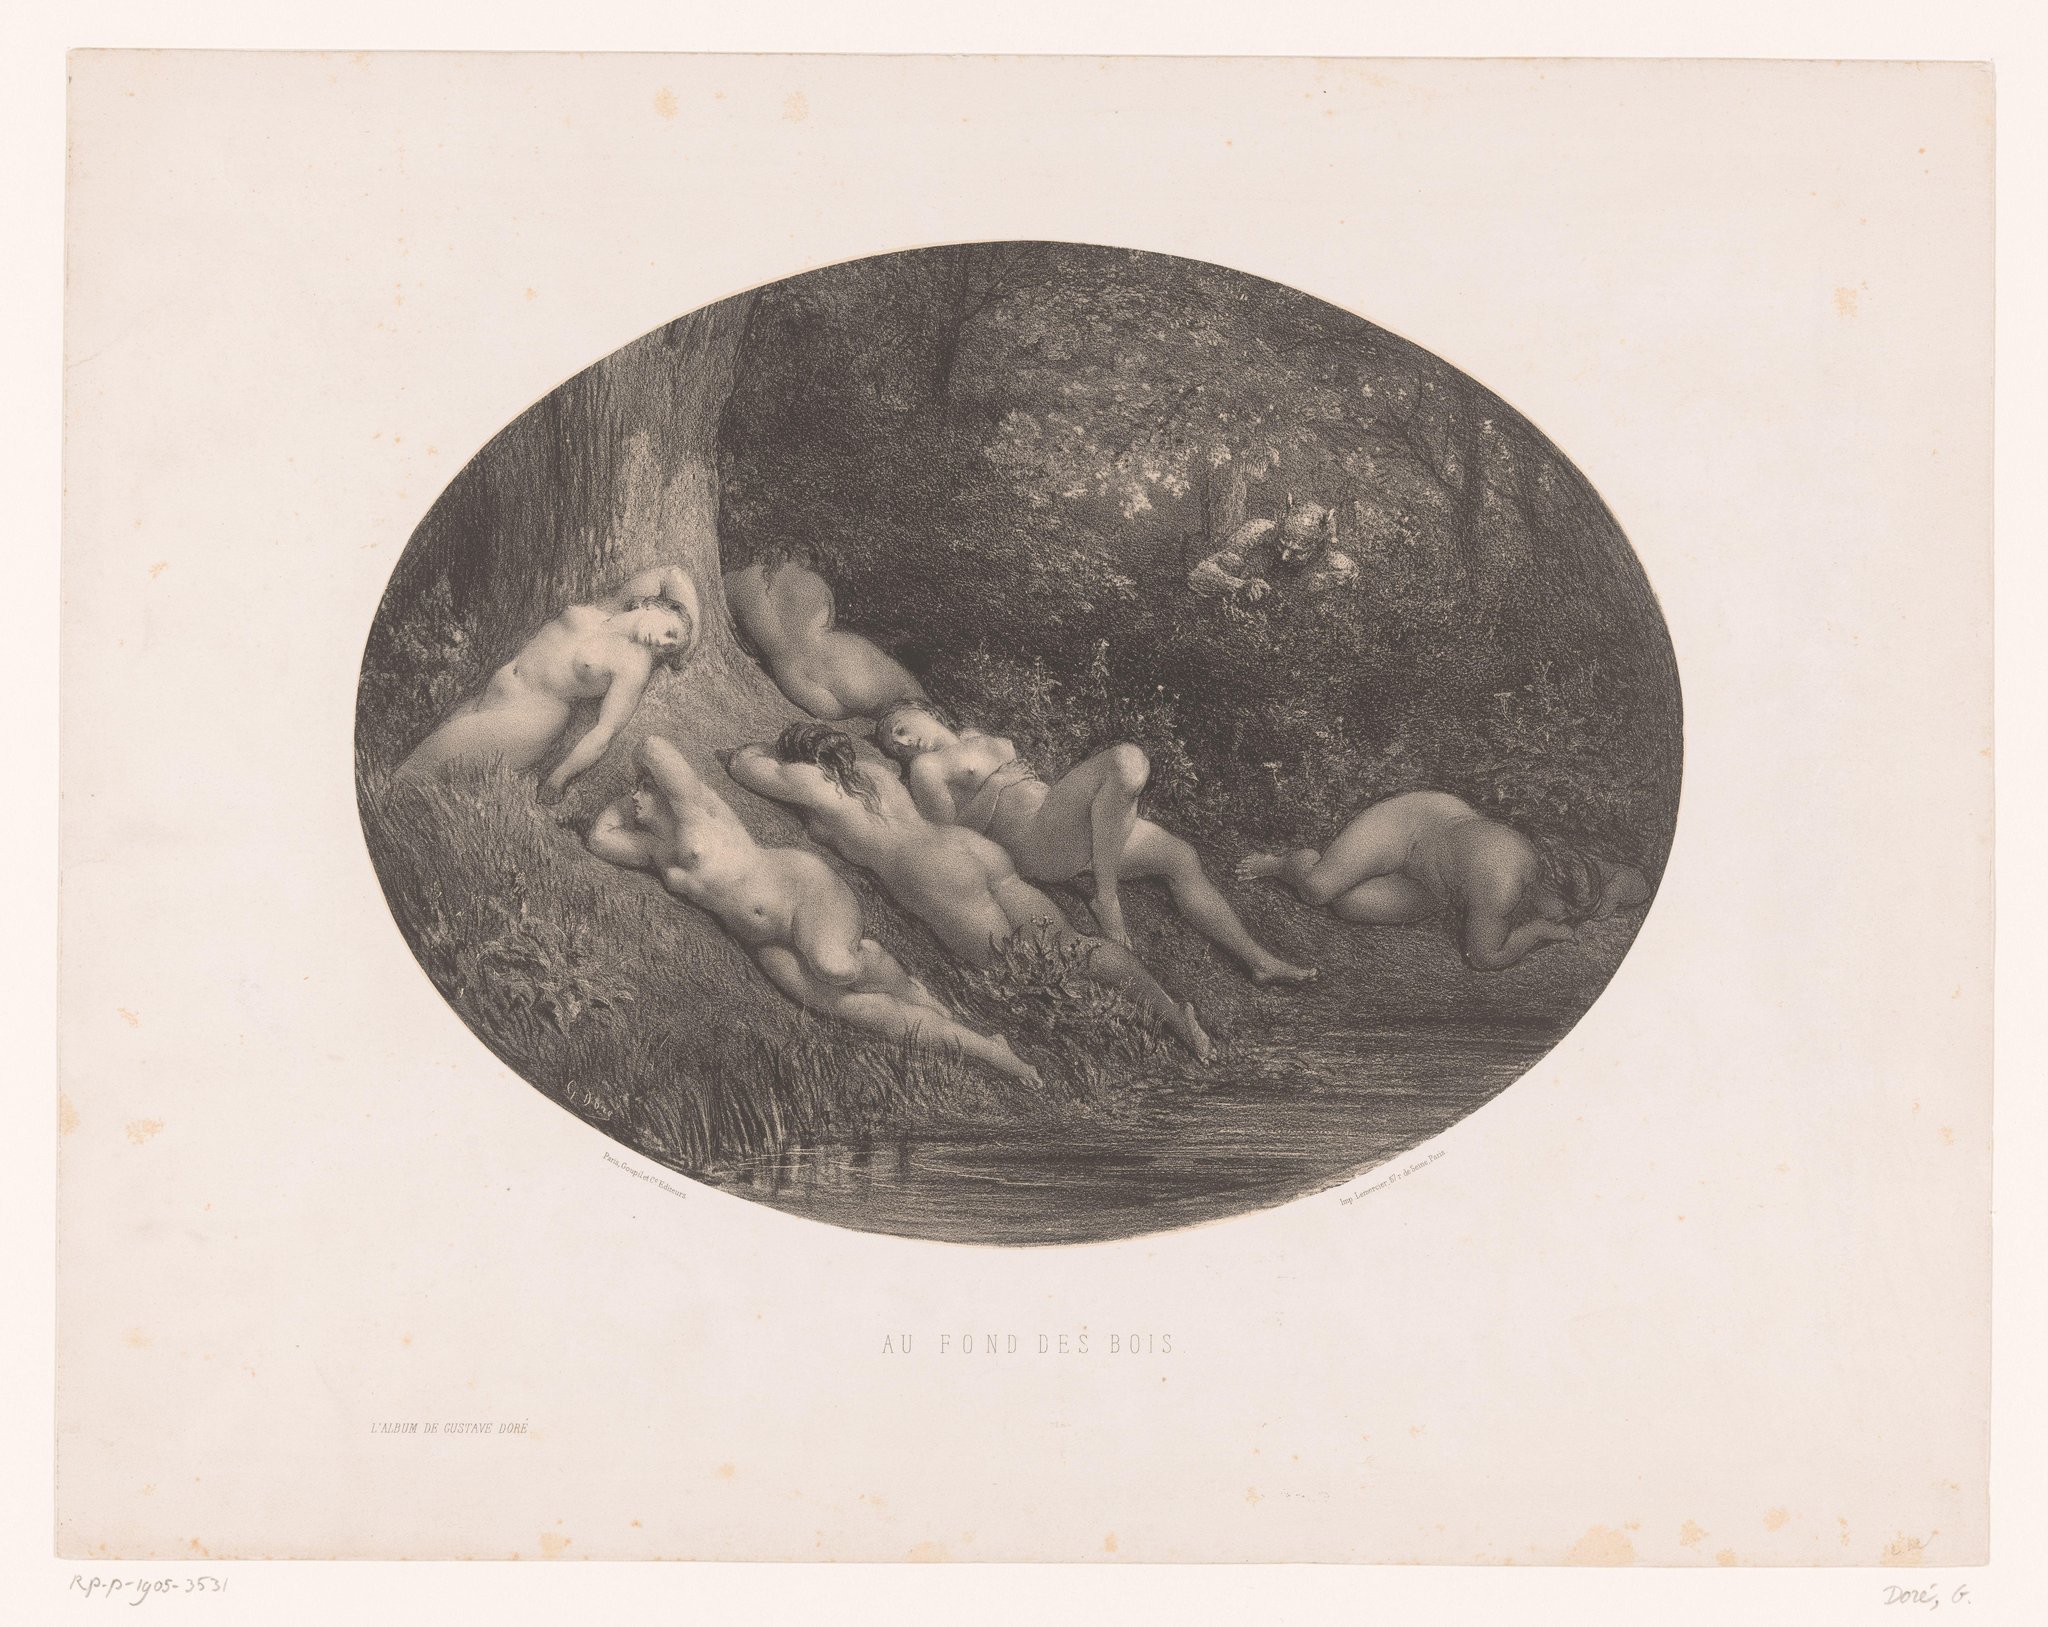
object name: print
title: Au fond des bois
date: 1862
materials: paper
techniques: lithograph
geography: paris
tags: nymphs (in general); 'ninfe in commune' (ripa), satyr(s) spying upon, forest, wood, the (nude) human figure; 'corpo humano' (ripa) - aa - female human figure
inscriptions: collector's mark: Lugt 2228a, check stamp: Lugt 1090